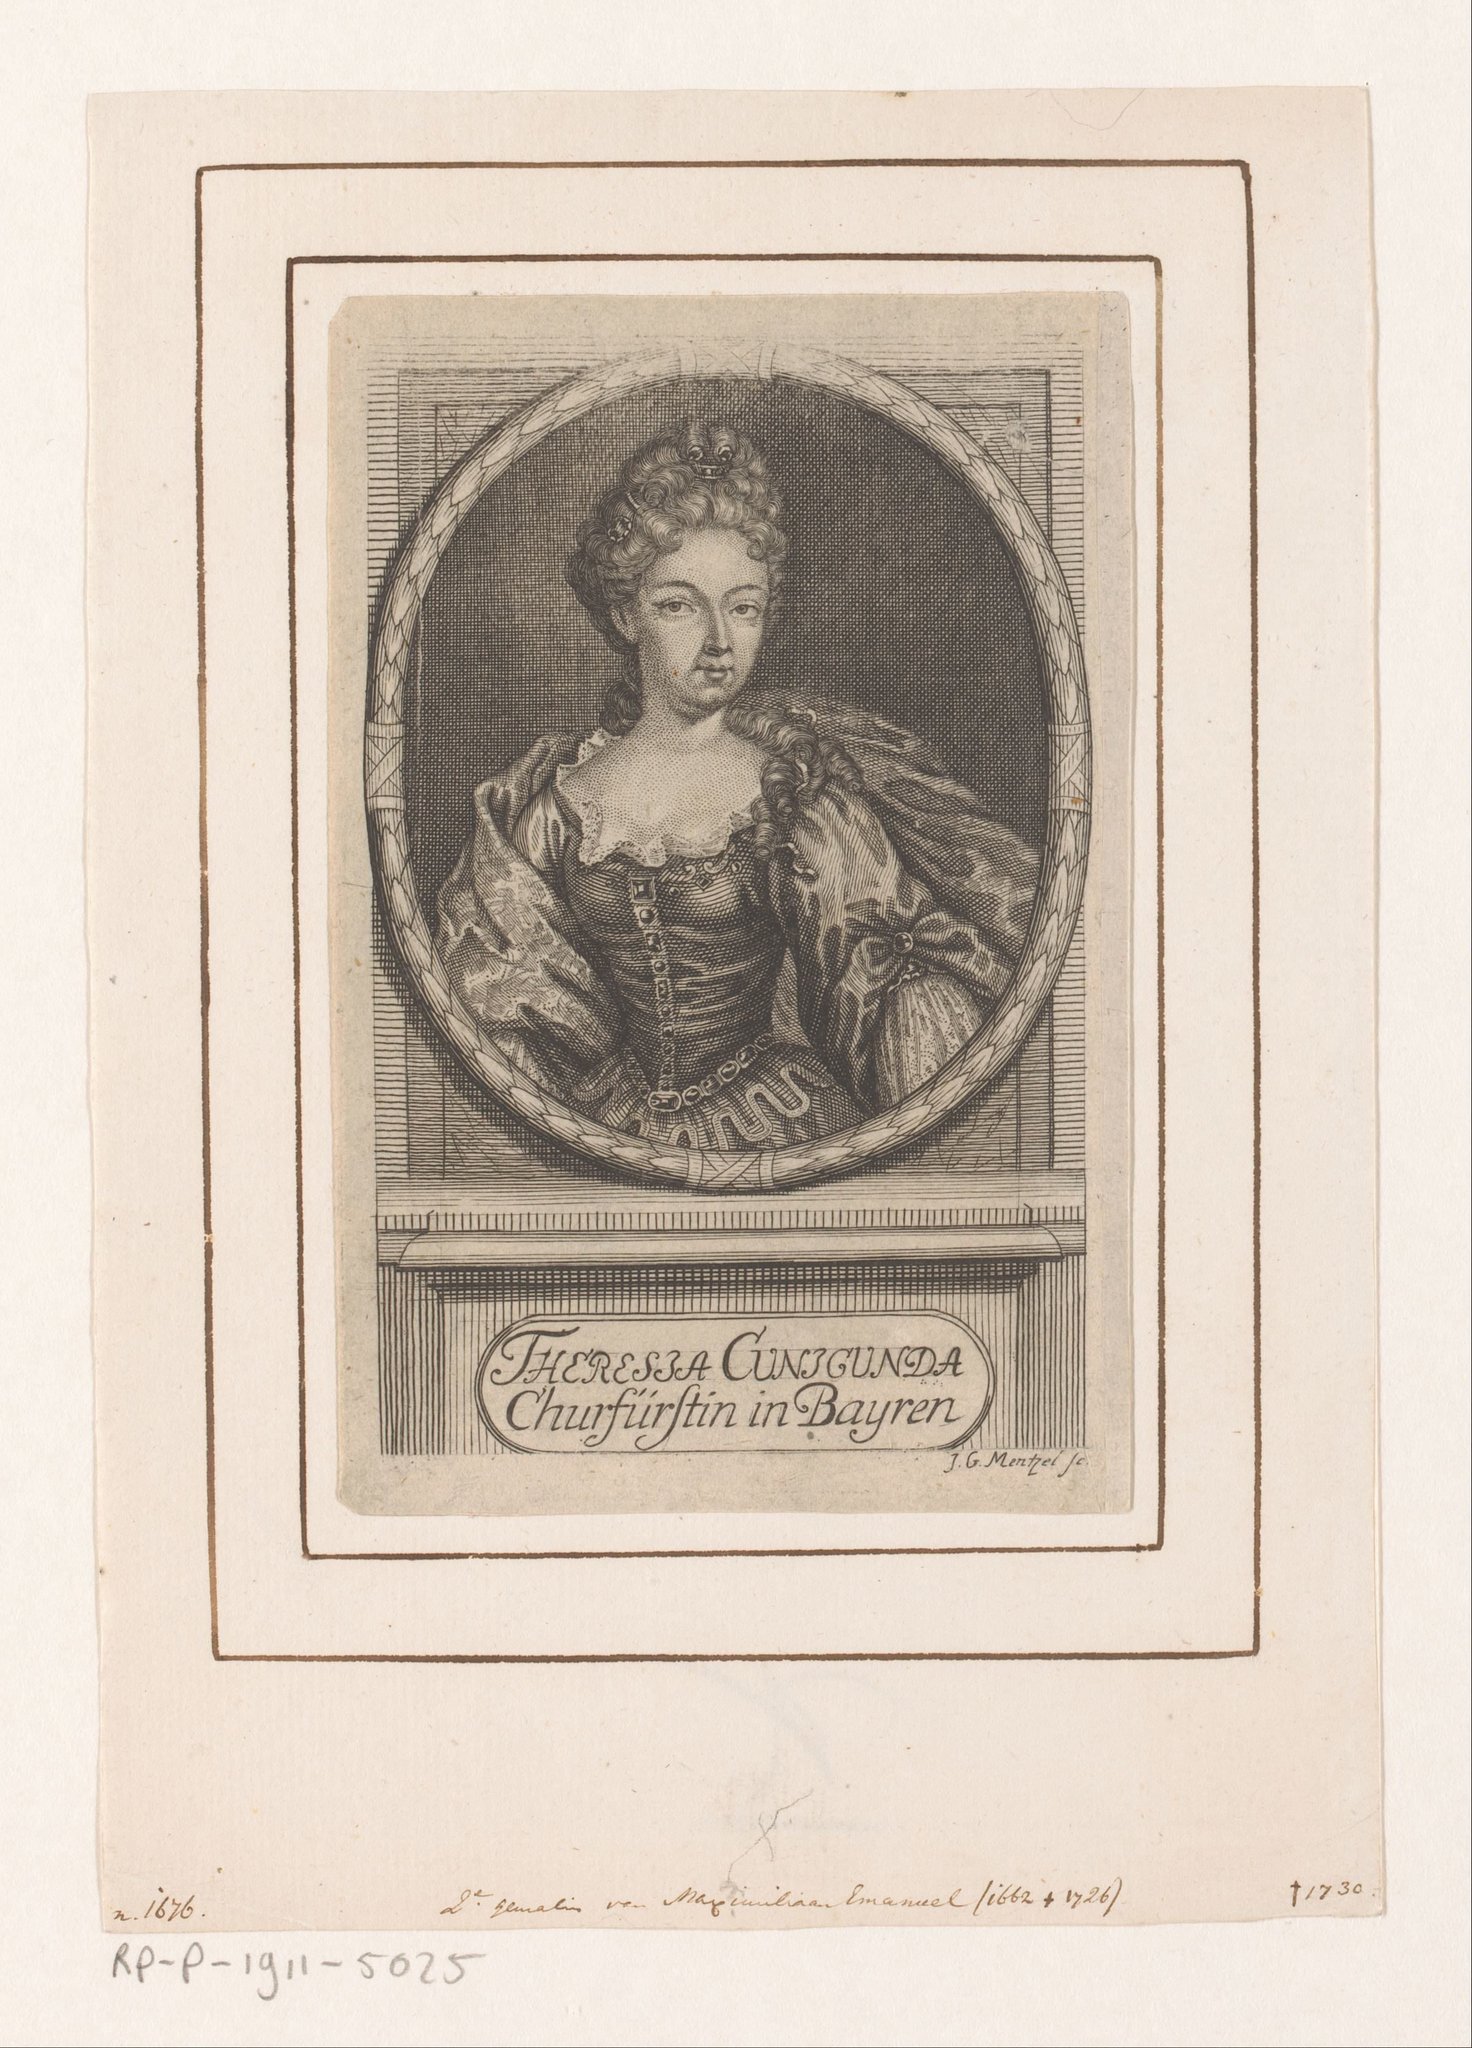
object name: print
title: Portret van prinses Theresia Kunigunde Sobieski van Polen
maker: johann georg mentzel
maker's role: print maker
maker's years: 1677-1743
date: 1687-1743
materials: paper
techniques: engraving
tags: venice, historical persons - bb - woman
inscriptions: collector's mark: Lugt 2228